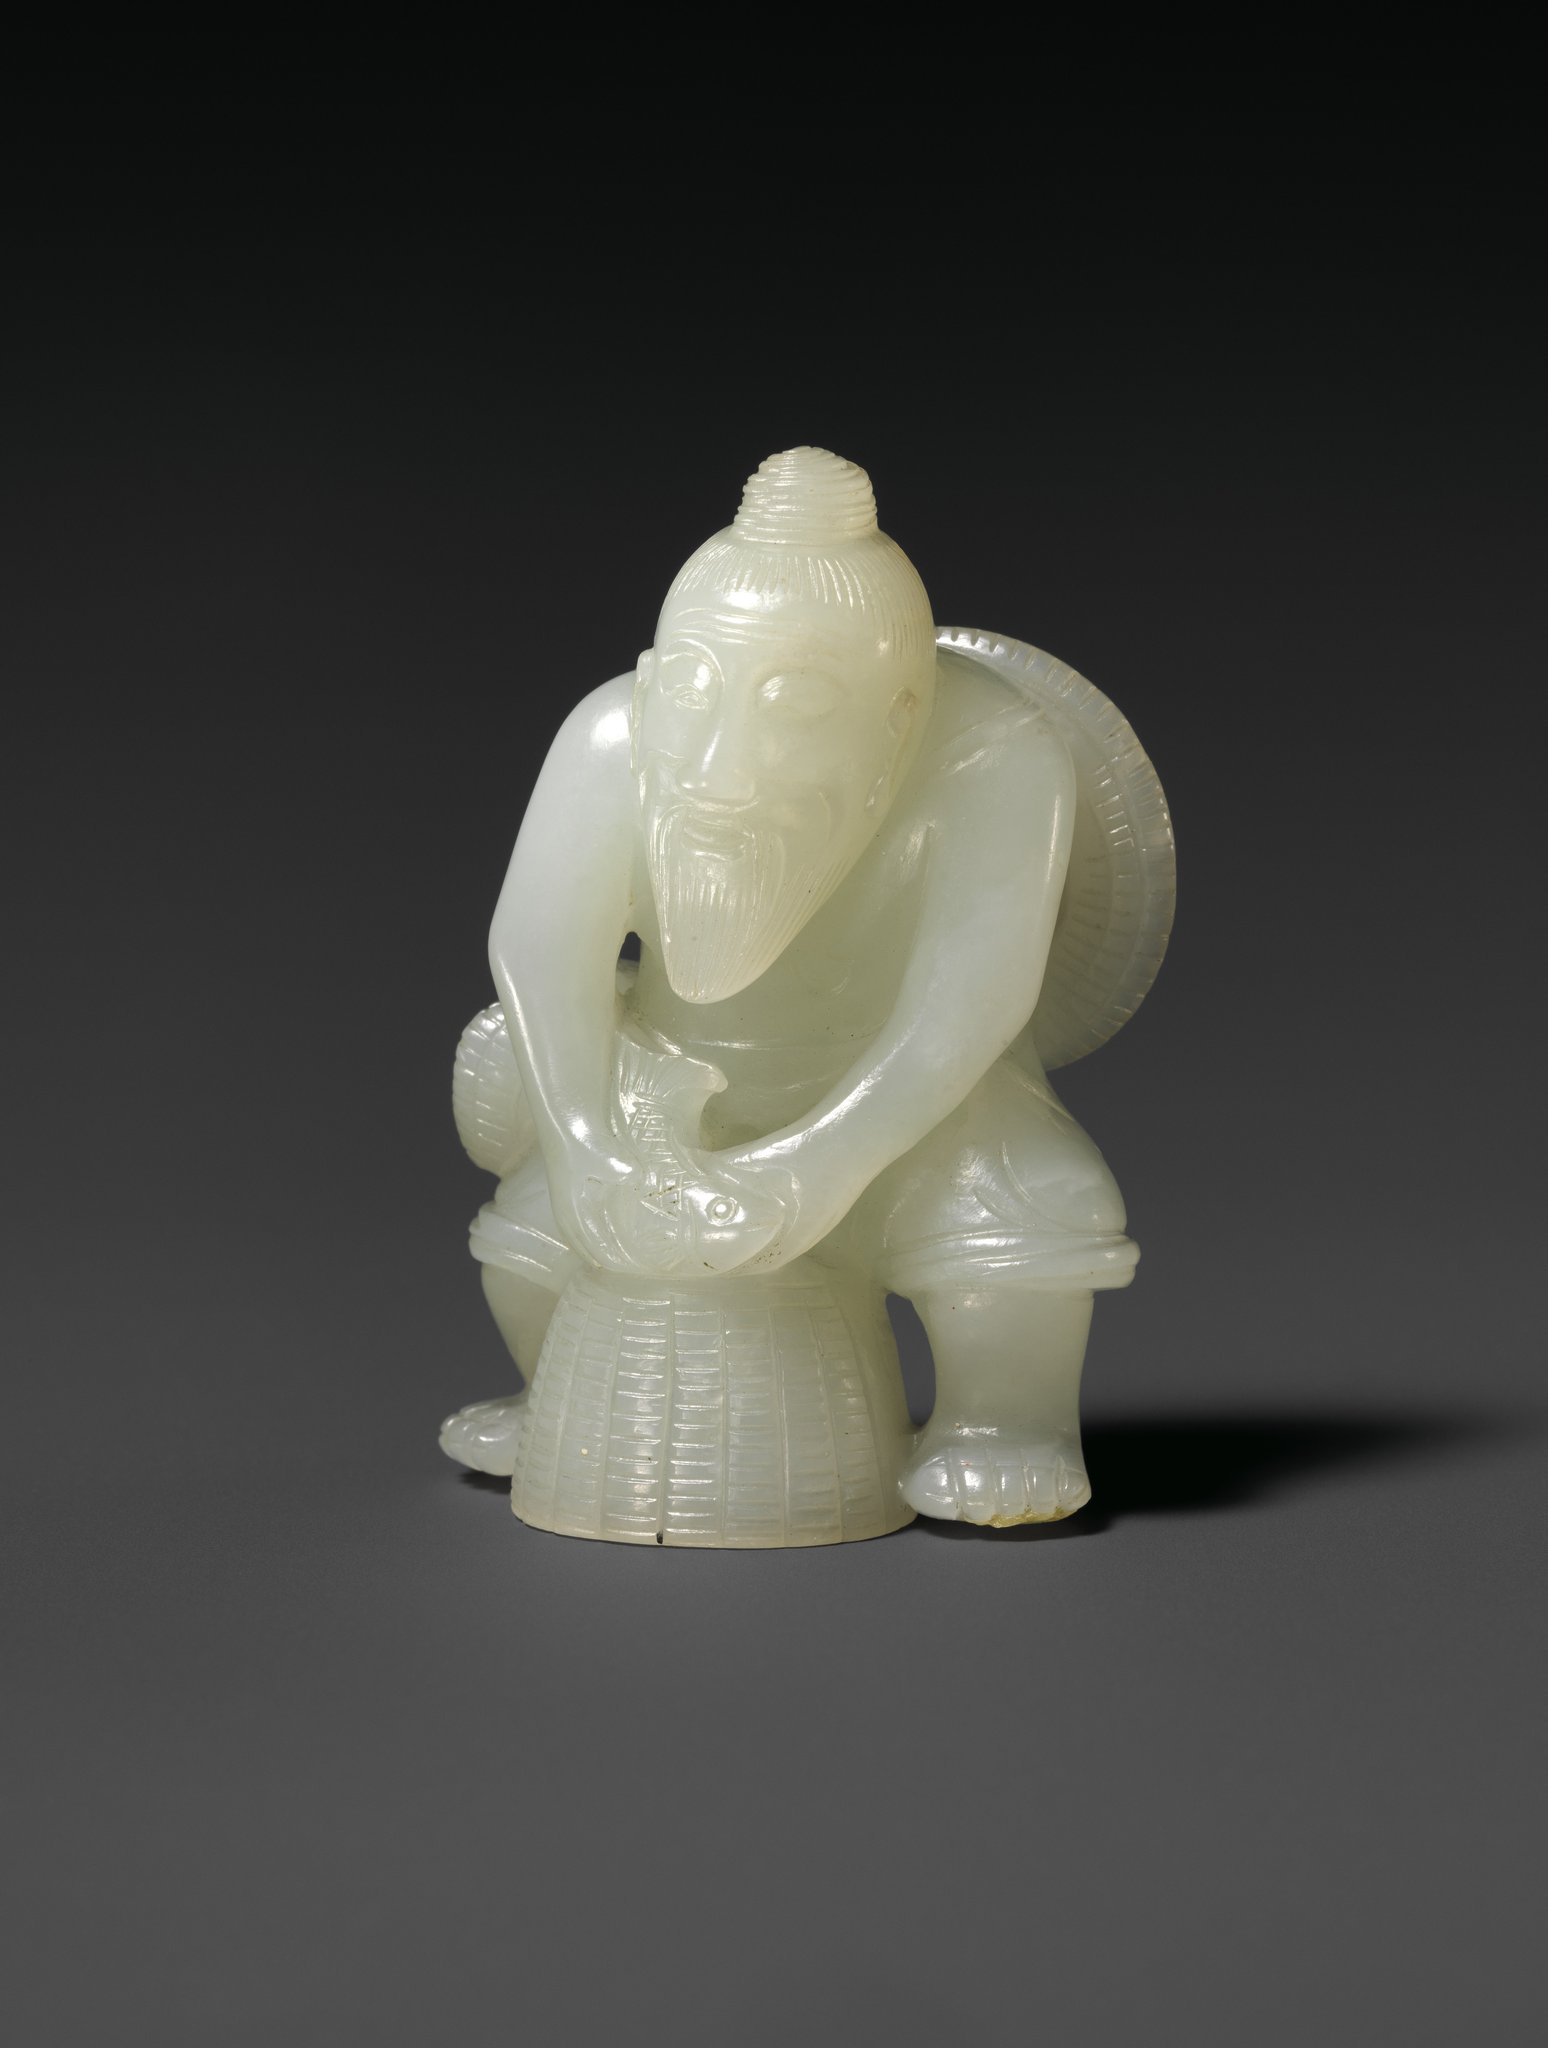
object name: figure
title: Figure of a fisherman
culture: chinese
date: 1701-1900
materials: jade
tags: men,fish